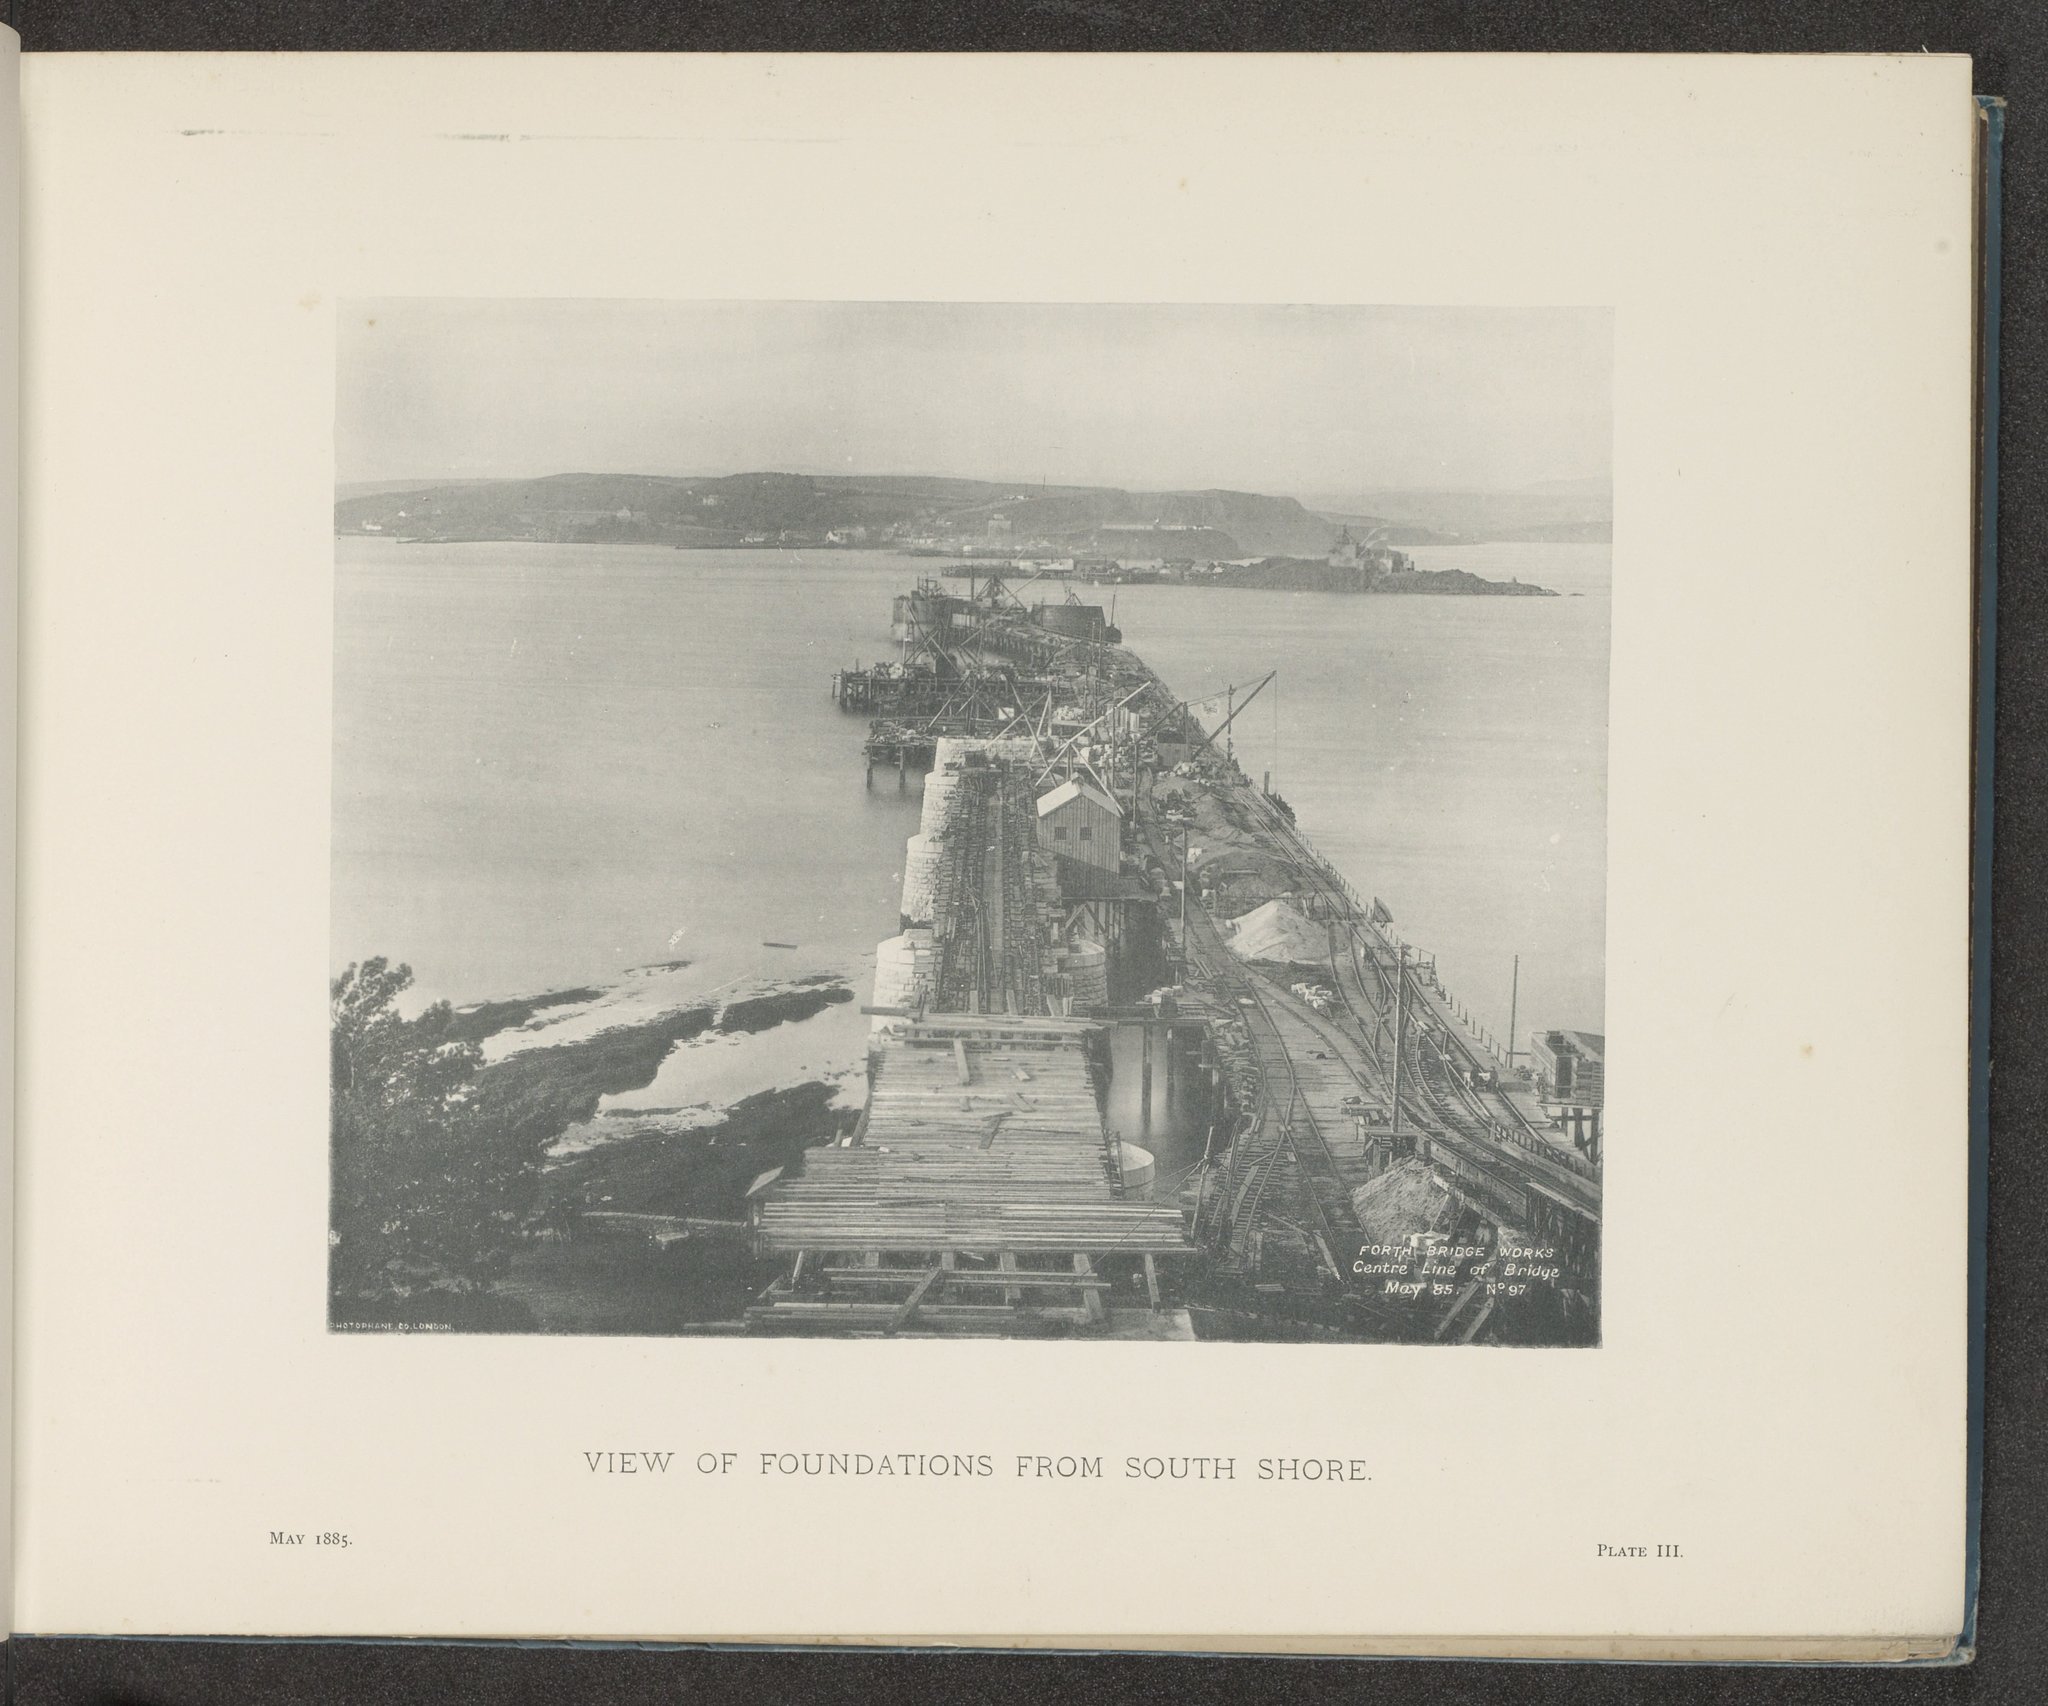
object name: photomechanical print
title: View of foundations from south shore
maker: Anonymous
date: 1805-1885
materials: paper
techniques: photograph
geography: london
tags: river, landscape with bridge, viaduct or aqueduct, building-site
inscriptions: inscription: ‘Forth Bridge works Centre Line of Bridge May 85. No 97’, number: ‘Plate III.’